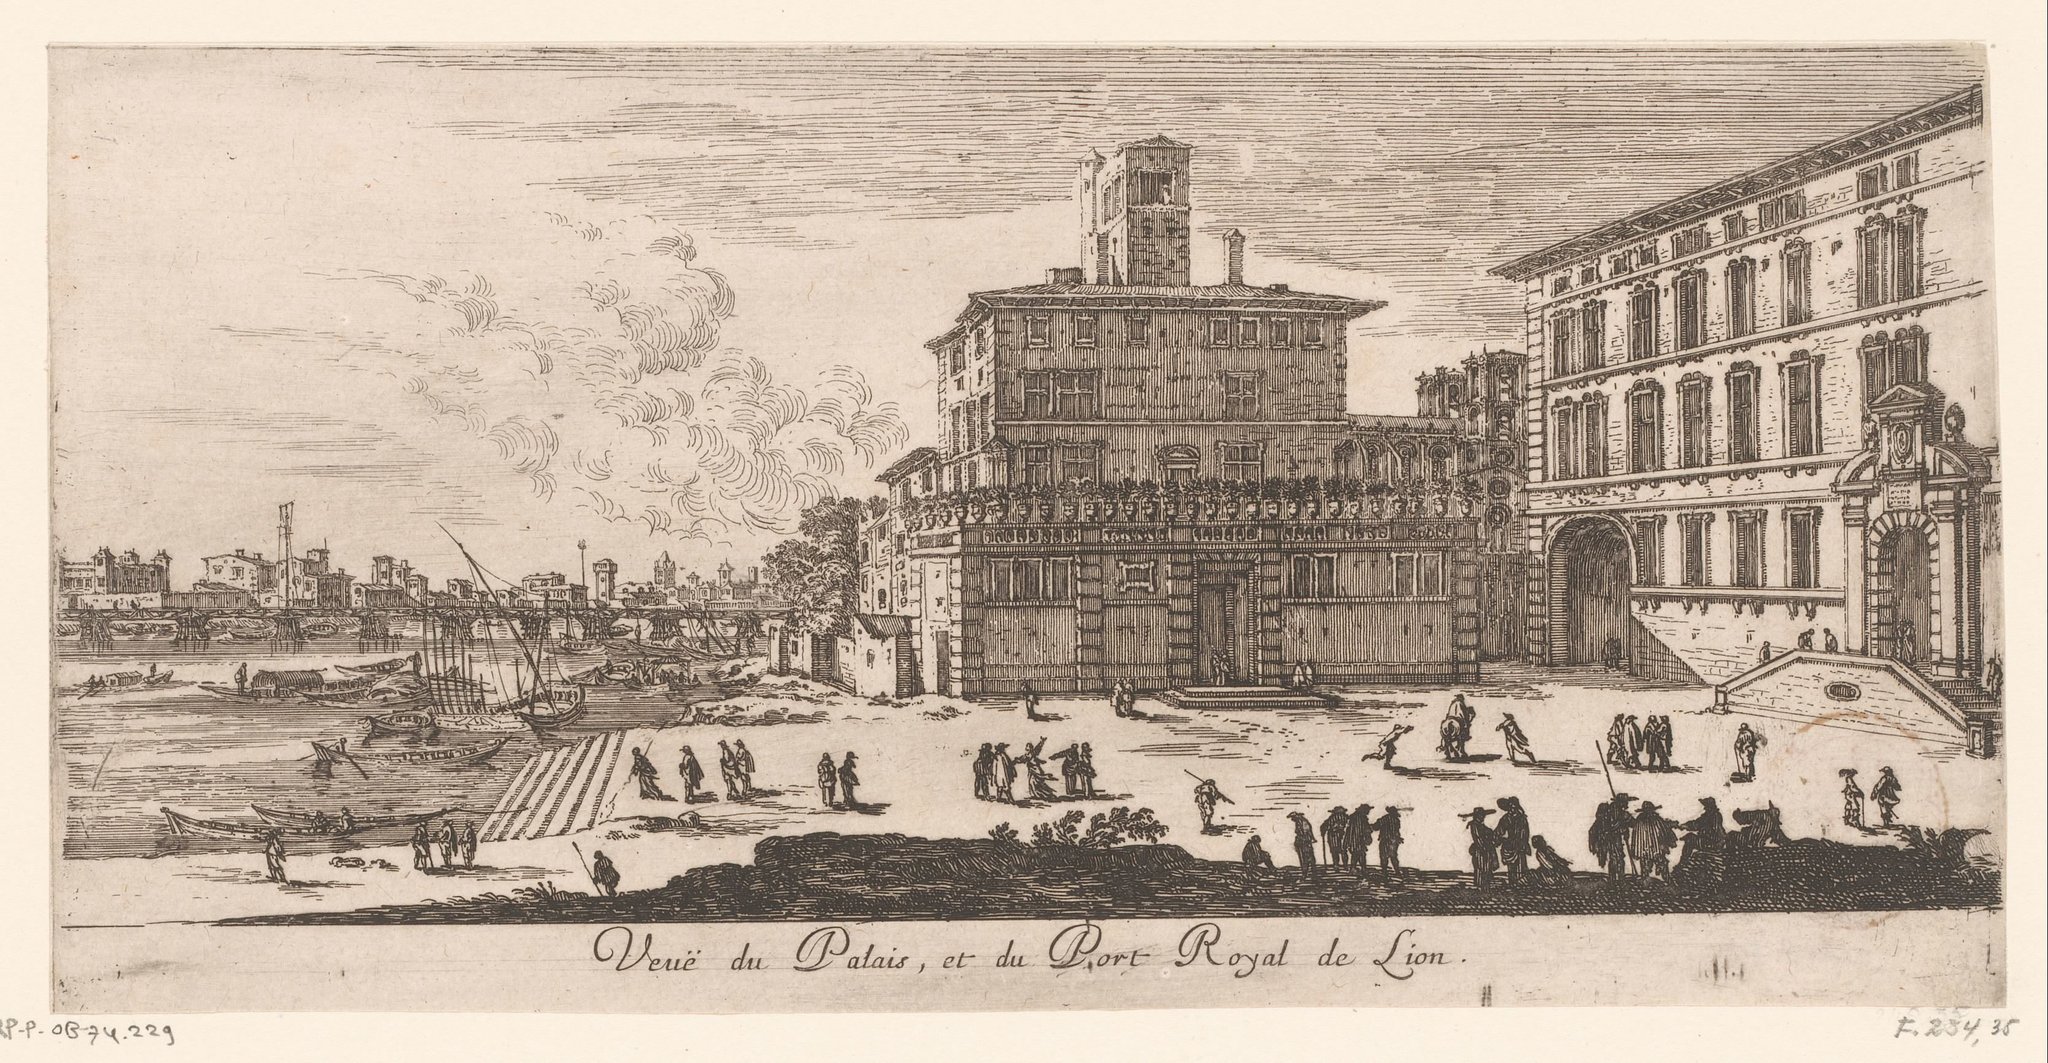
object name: print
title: Veue du Palais et du Port Royal de Lion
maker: israël silvestre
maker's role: draughtsman, print maker, publisher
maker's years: 1621-1691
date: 1652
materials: paper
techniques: engraving, etching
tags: city-view, and landscape with man-made constructions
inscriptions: collector's mark: Lugt 240